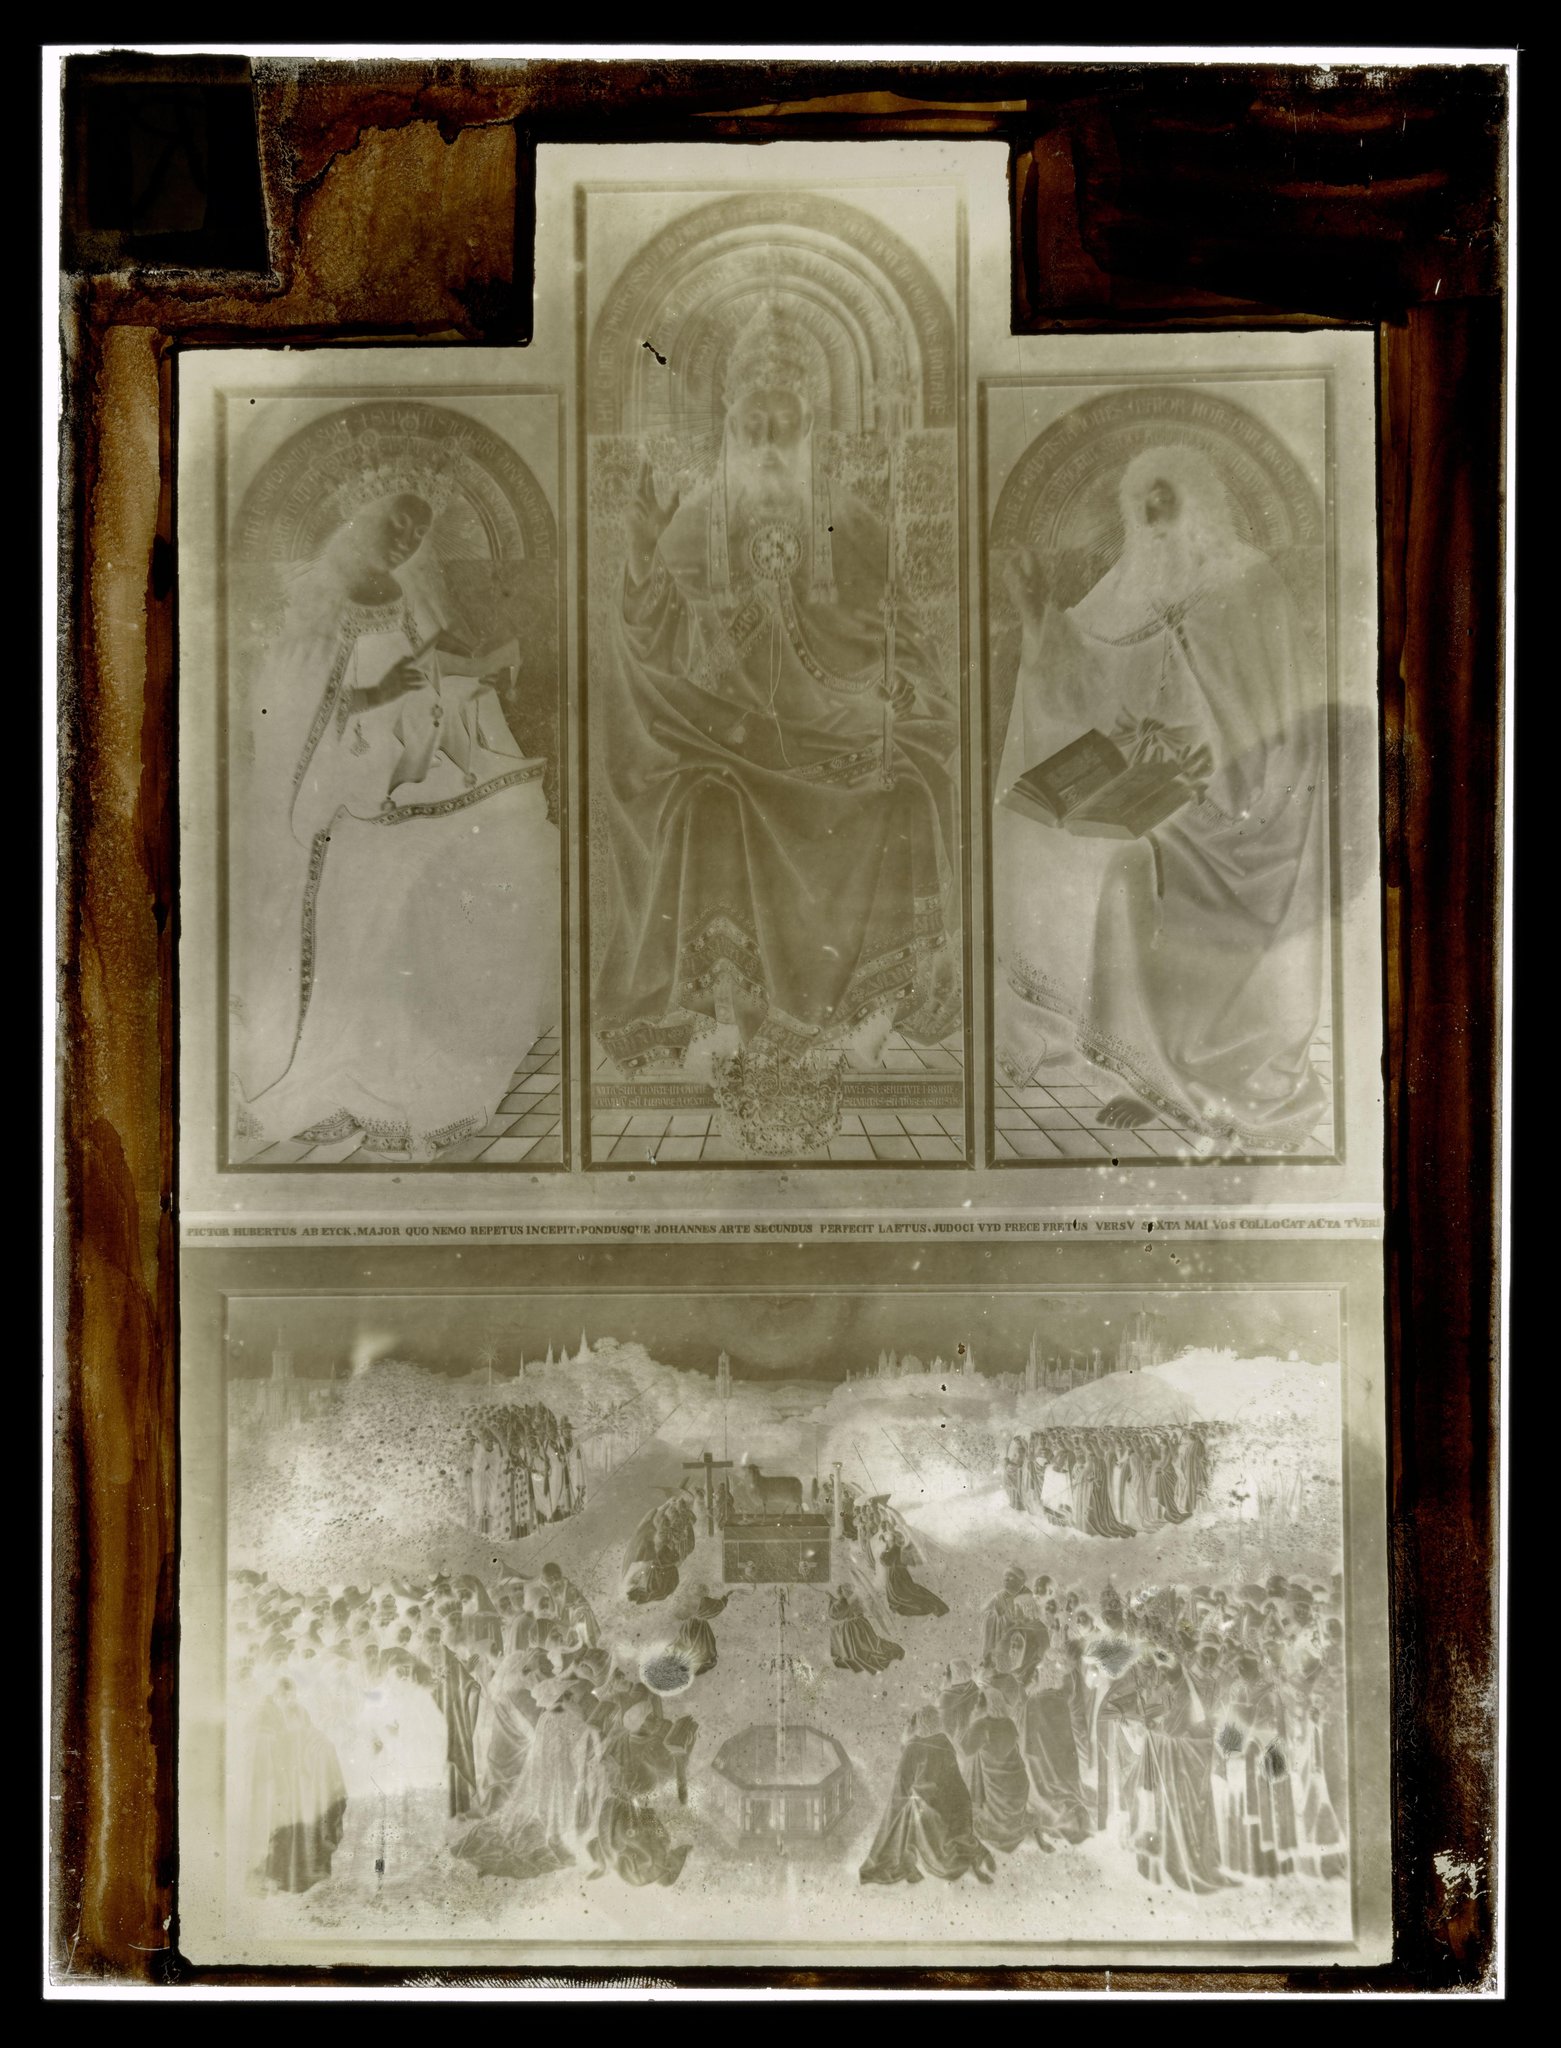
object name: negative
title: Deelnegatief van het middenpaneel van het altaarstuk De aanbidding van het Lam Gods door Hubert en Jan van Eyck, opgesteld in de Sint-Baafskathedraal, Gent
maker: Anonymous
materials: glass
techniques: gelatin silver negative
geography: ghent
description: Gefotografeerd door een rood- en groenfilter.